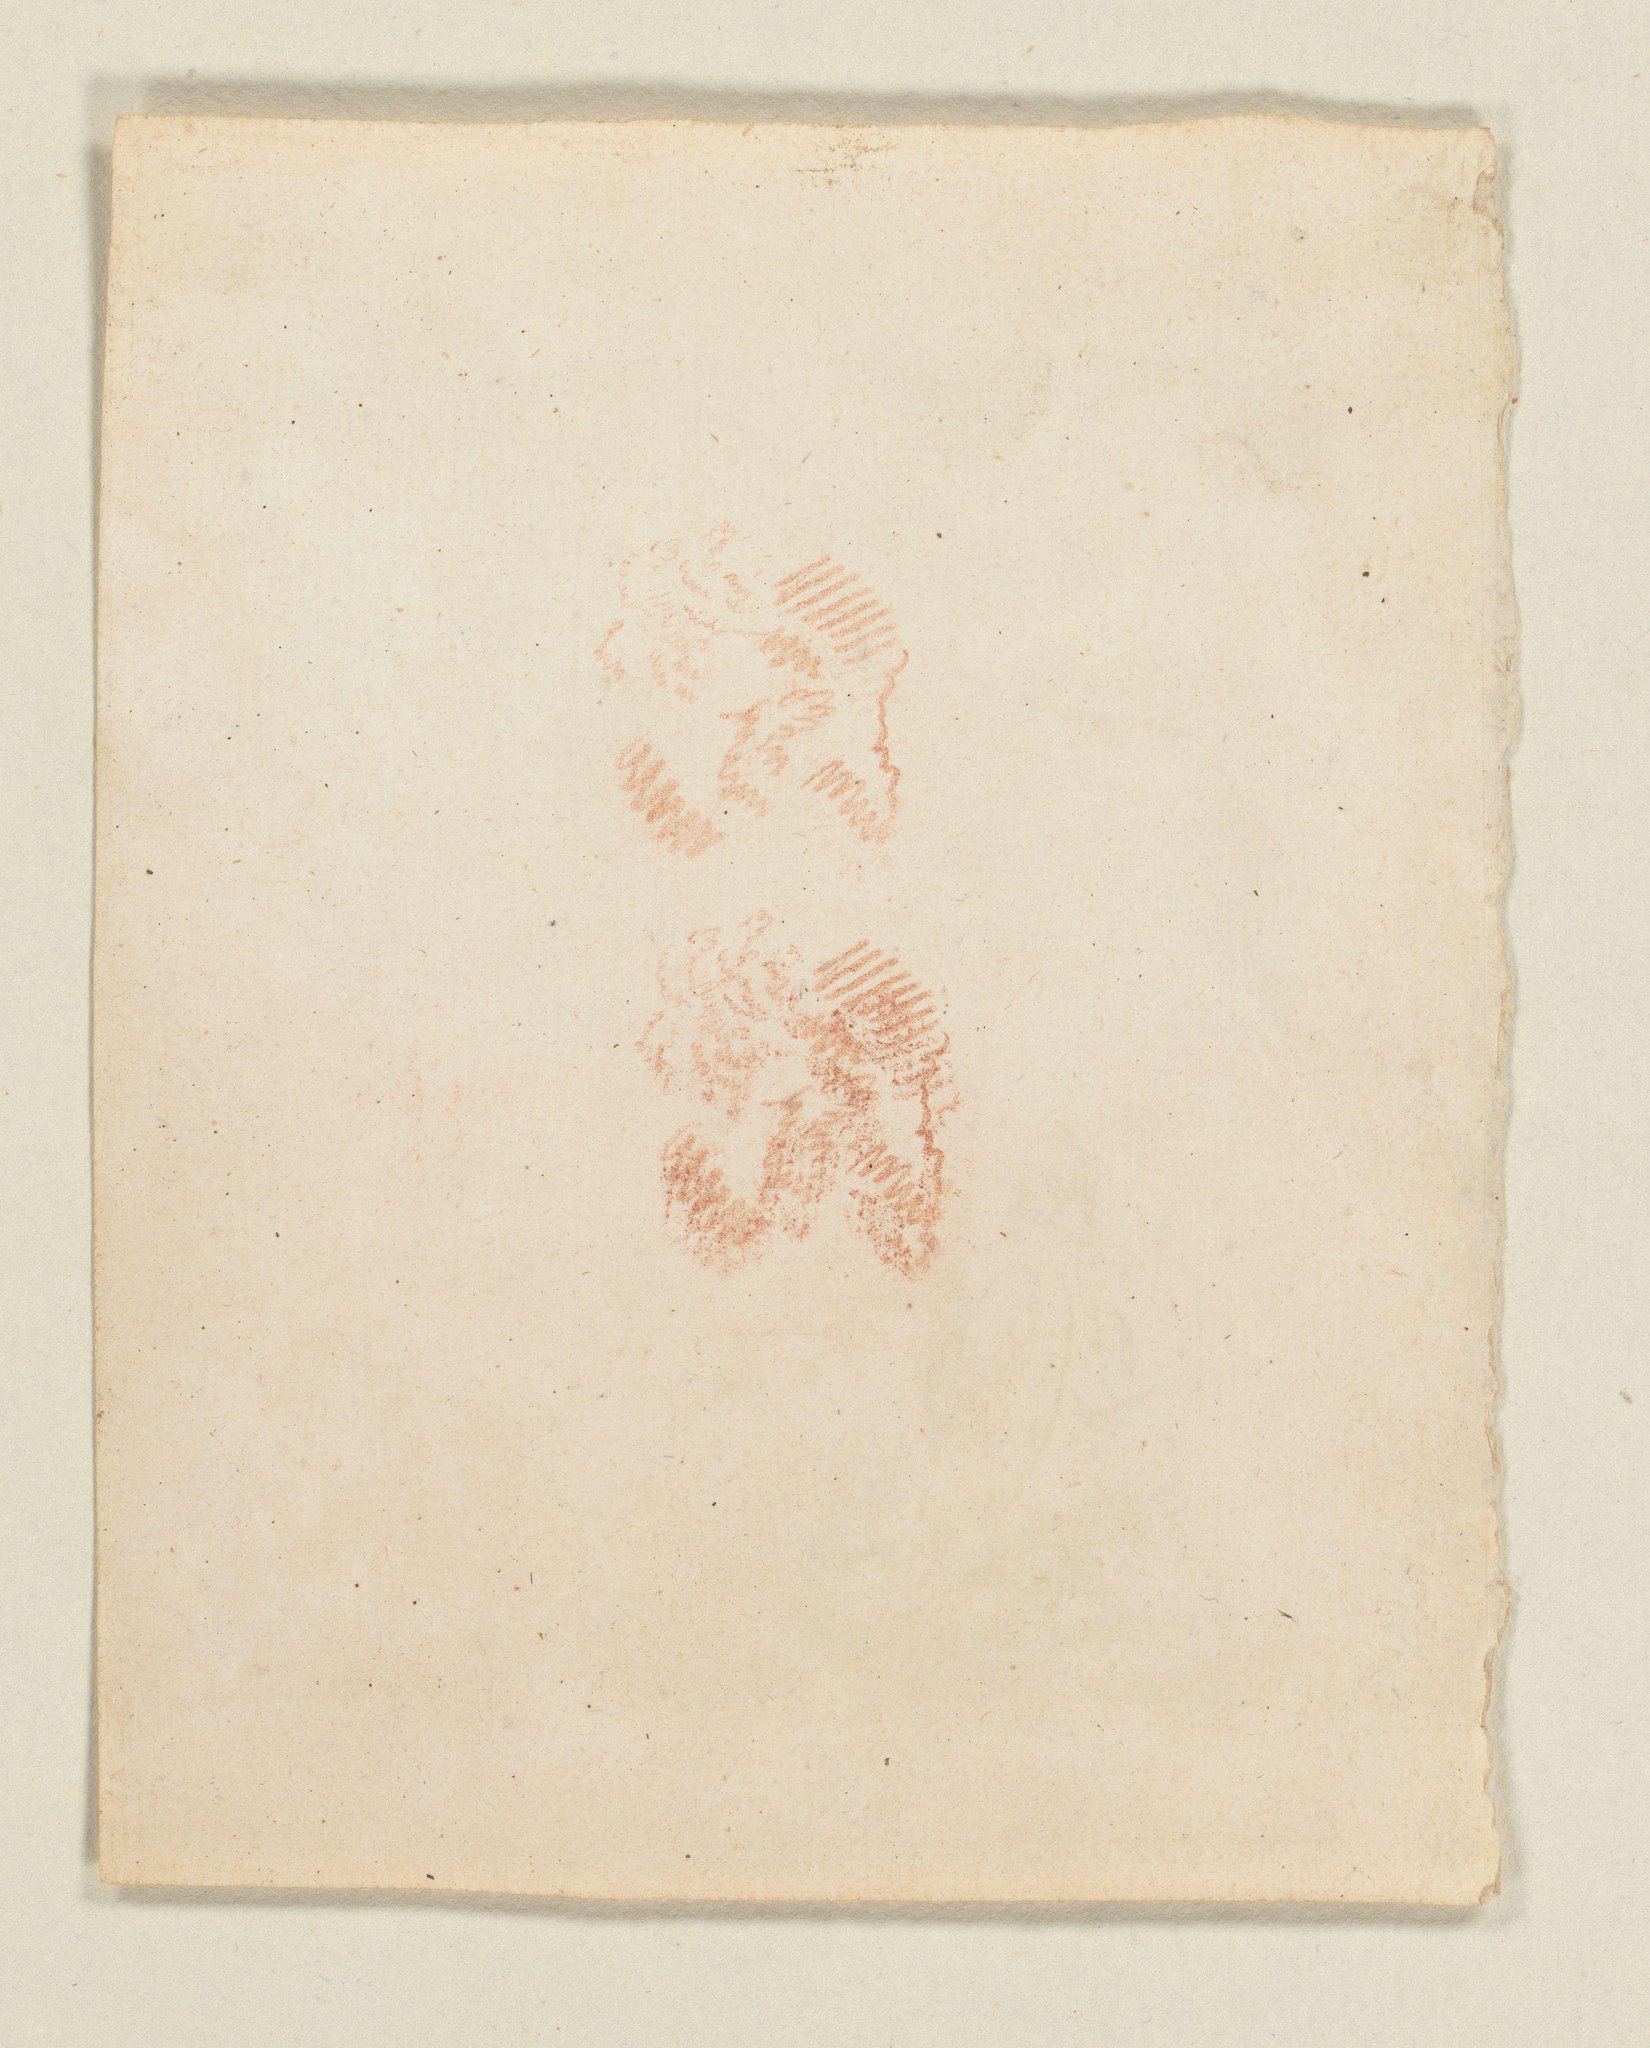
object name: print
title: Proef van grafische techniek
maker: cornelis ploos van amstel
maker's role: draughtsman, print maker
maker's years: 1726-1798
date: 1736-1798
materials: paper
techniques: printmaking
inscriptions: collector's mark: Lugt 2725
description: Blad met een proef om een tekening in rood krijt in prent te brengen. De prent ligt los achterin een album.